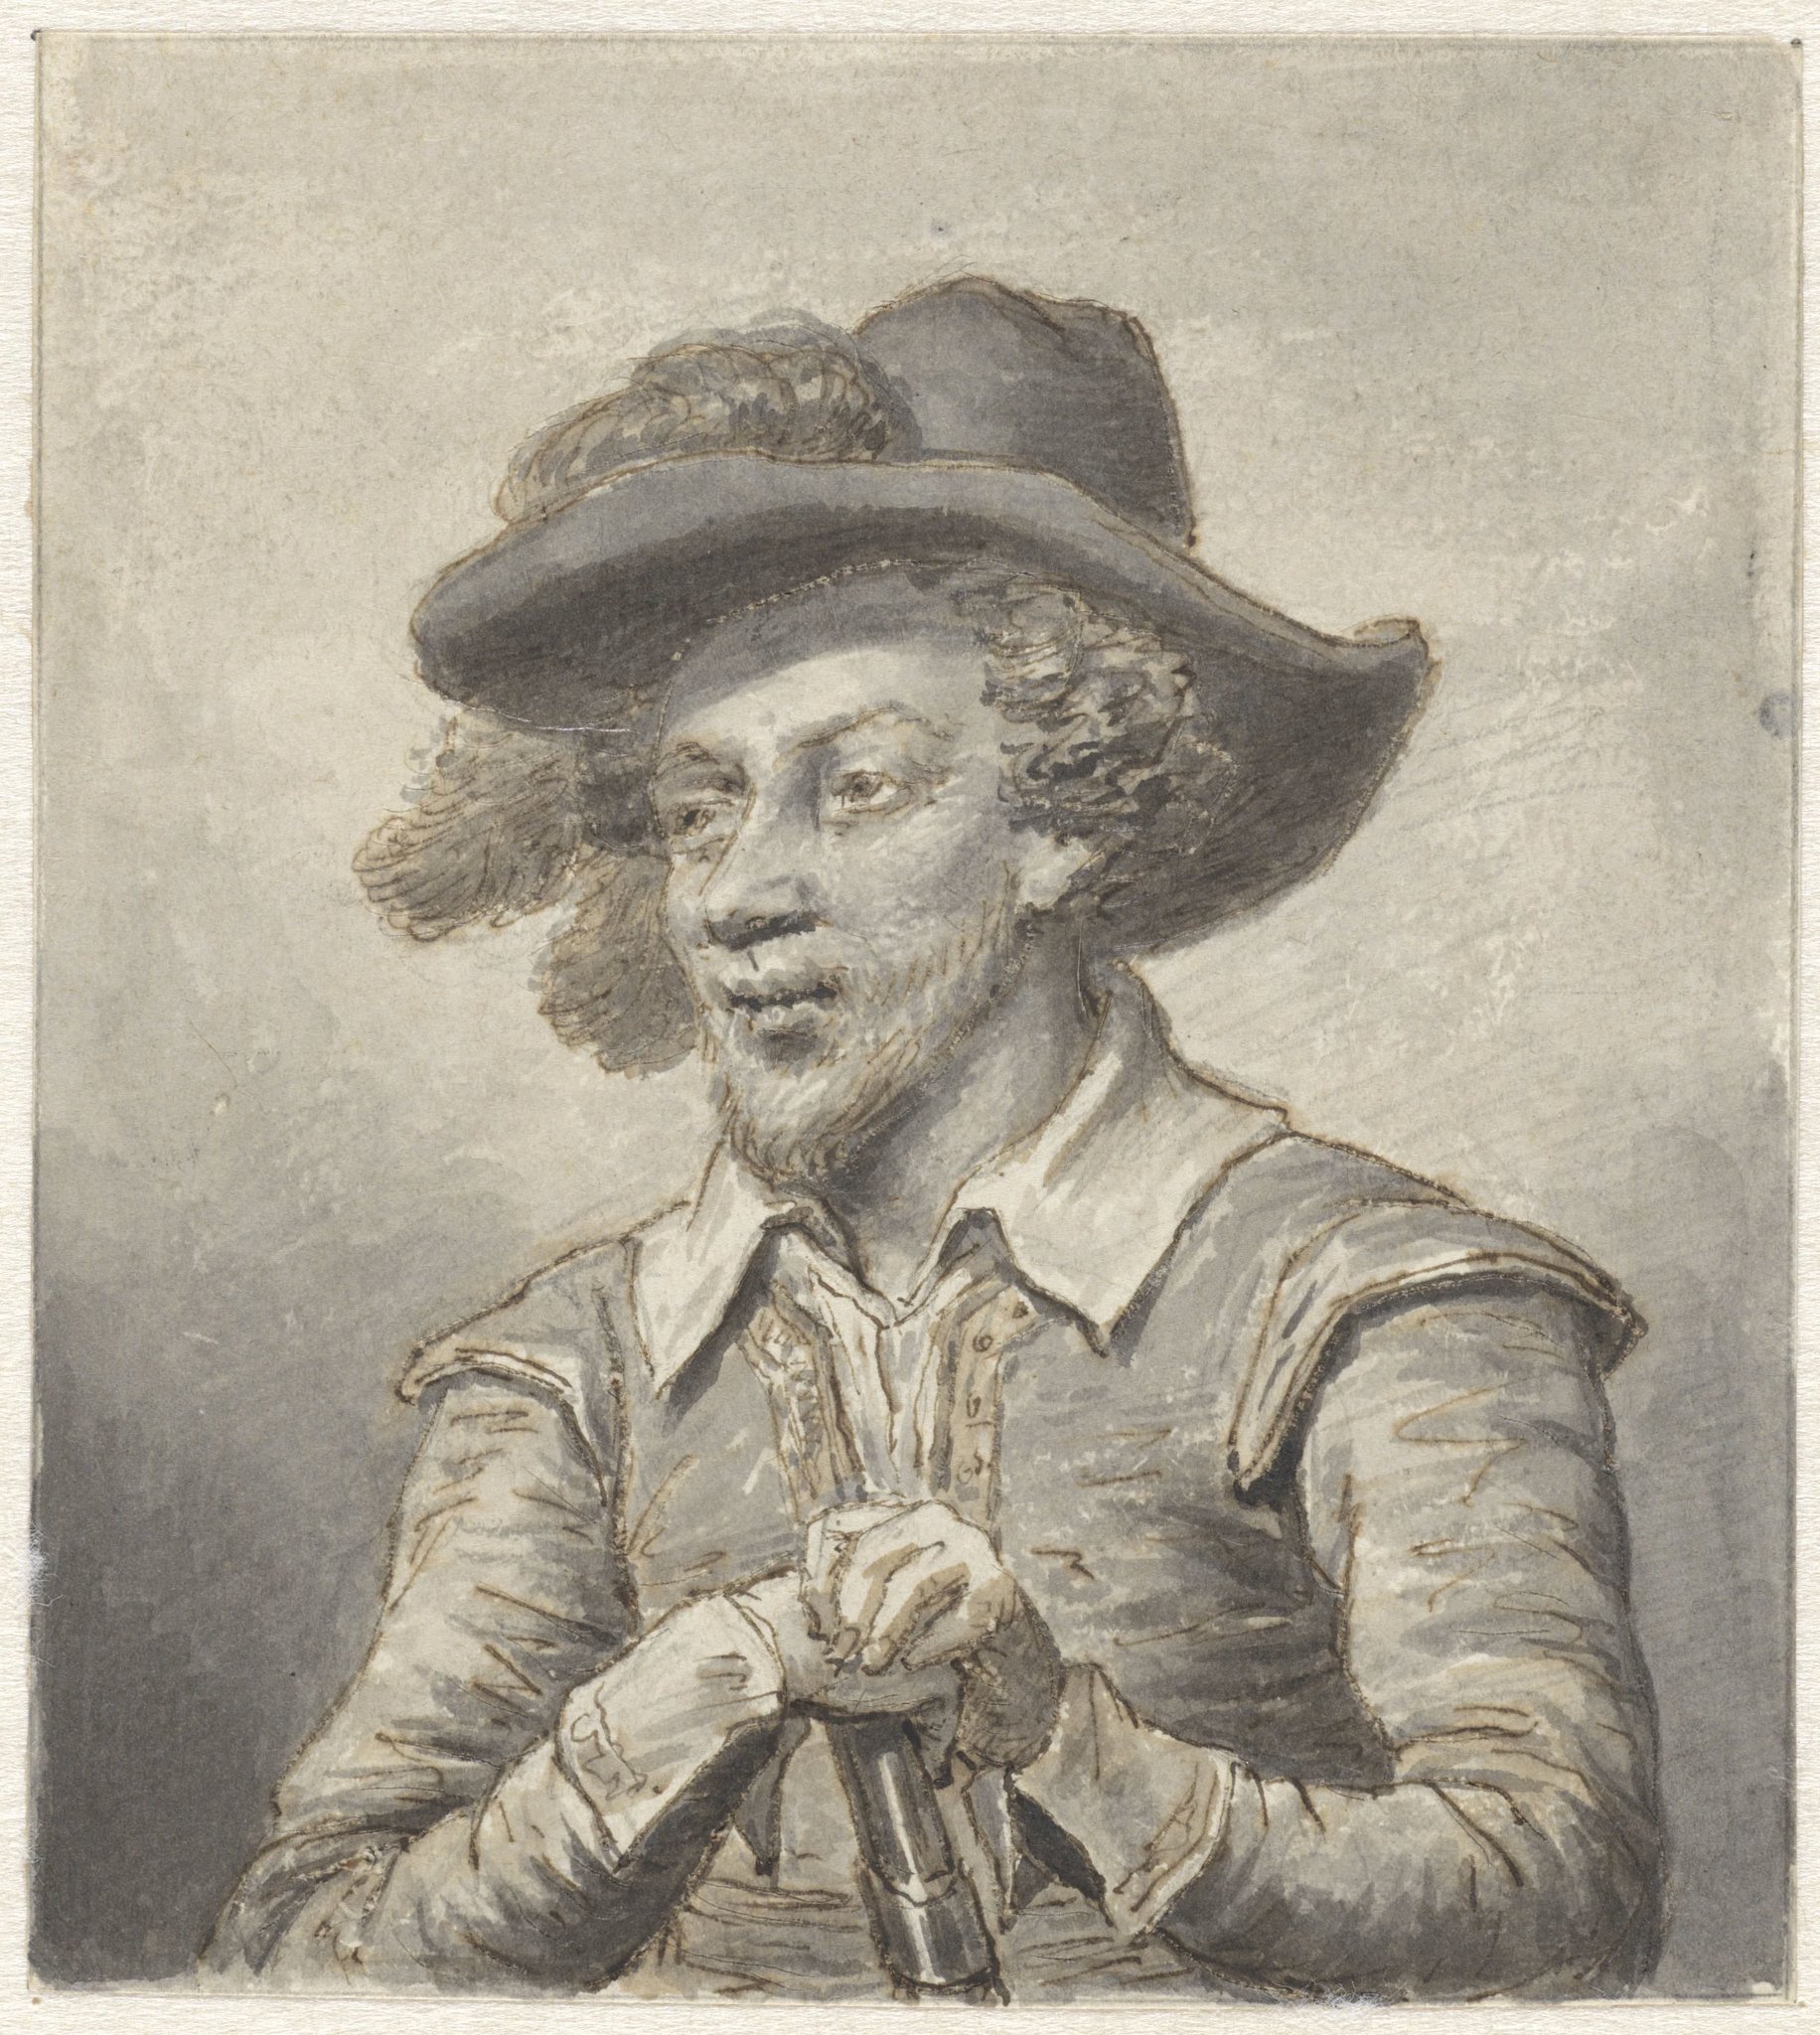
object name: design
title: Krijgsman in historisch kostuum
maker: christiaan kramm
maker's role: draughtsman, print maker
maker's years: 1797-1875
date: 1807-1875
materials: chalk, ink, paper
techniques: brush, pen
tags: private soldier